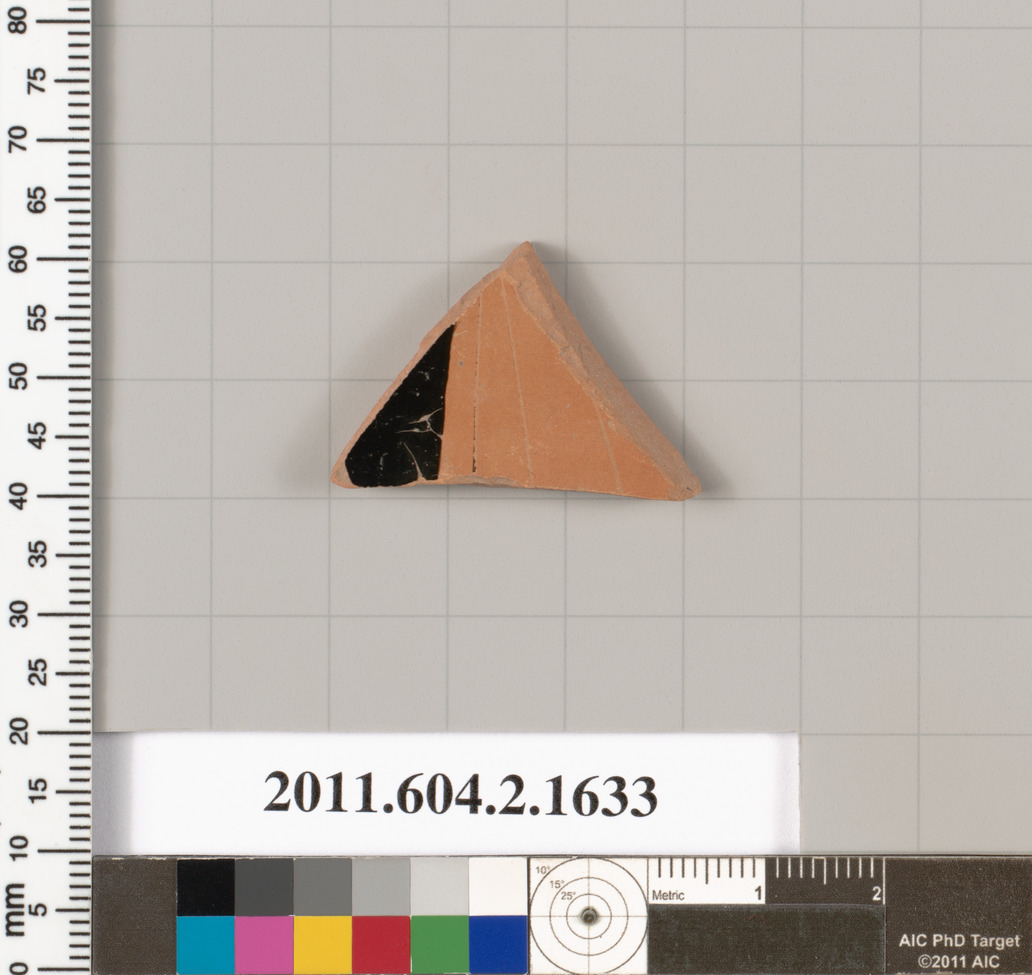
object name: skyphos fragment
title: Terracotta fragment of a skyphos (deep drinking cup)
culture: greek, attic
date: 460-440 BCE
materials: terracotta